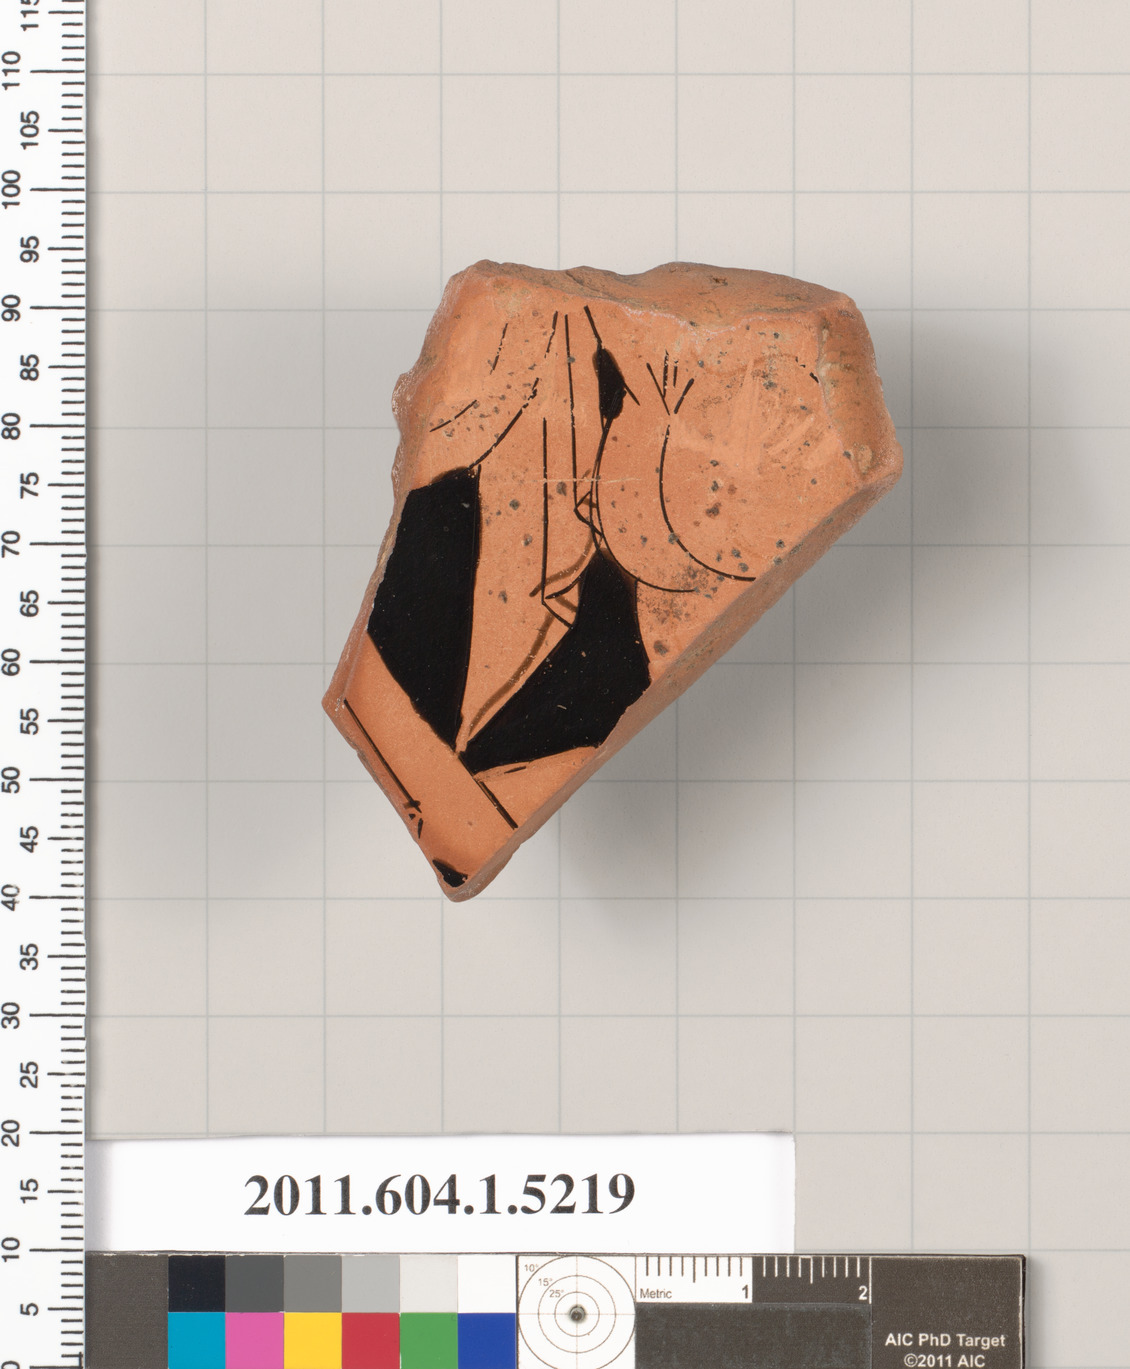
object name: kylix fragment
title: Terracotta fragment of a kylix (drinking cup)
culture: greek, attic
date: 490-470 BCE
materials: terracotta